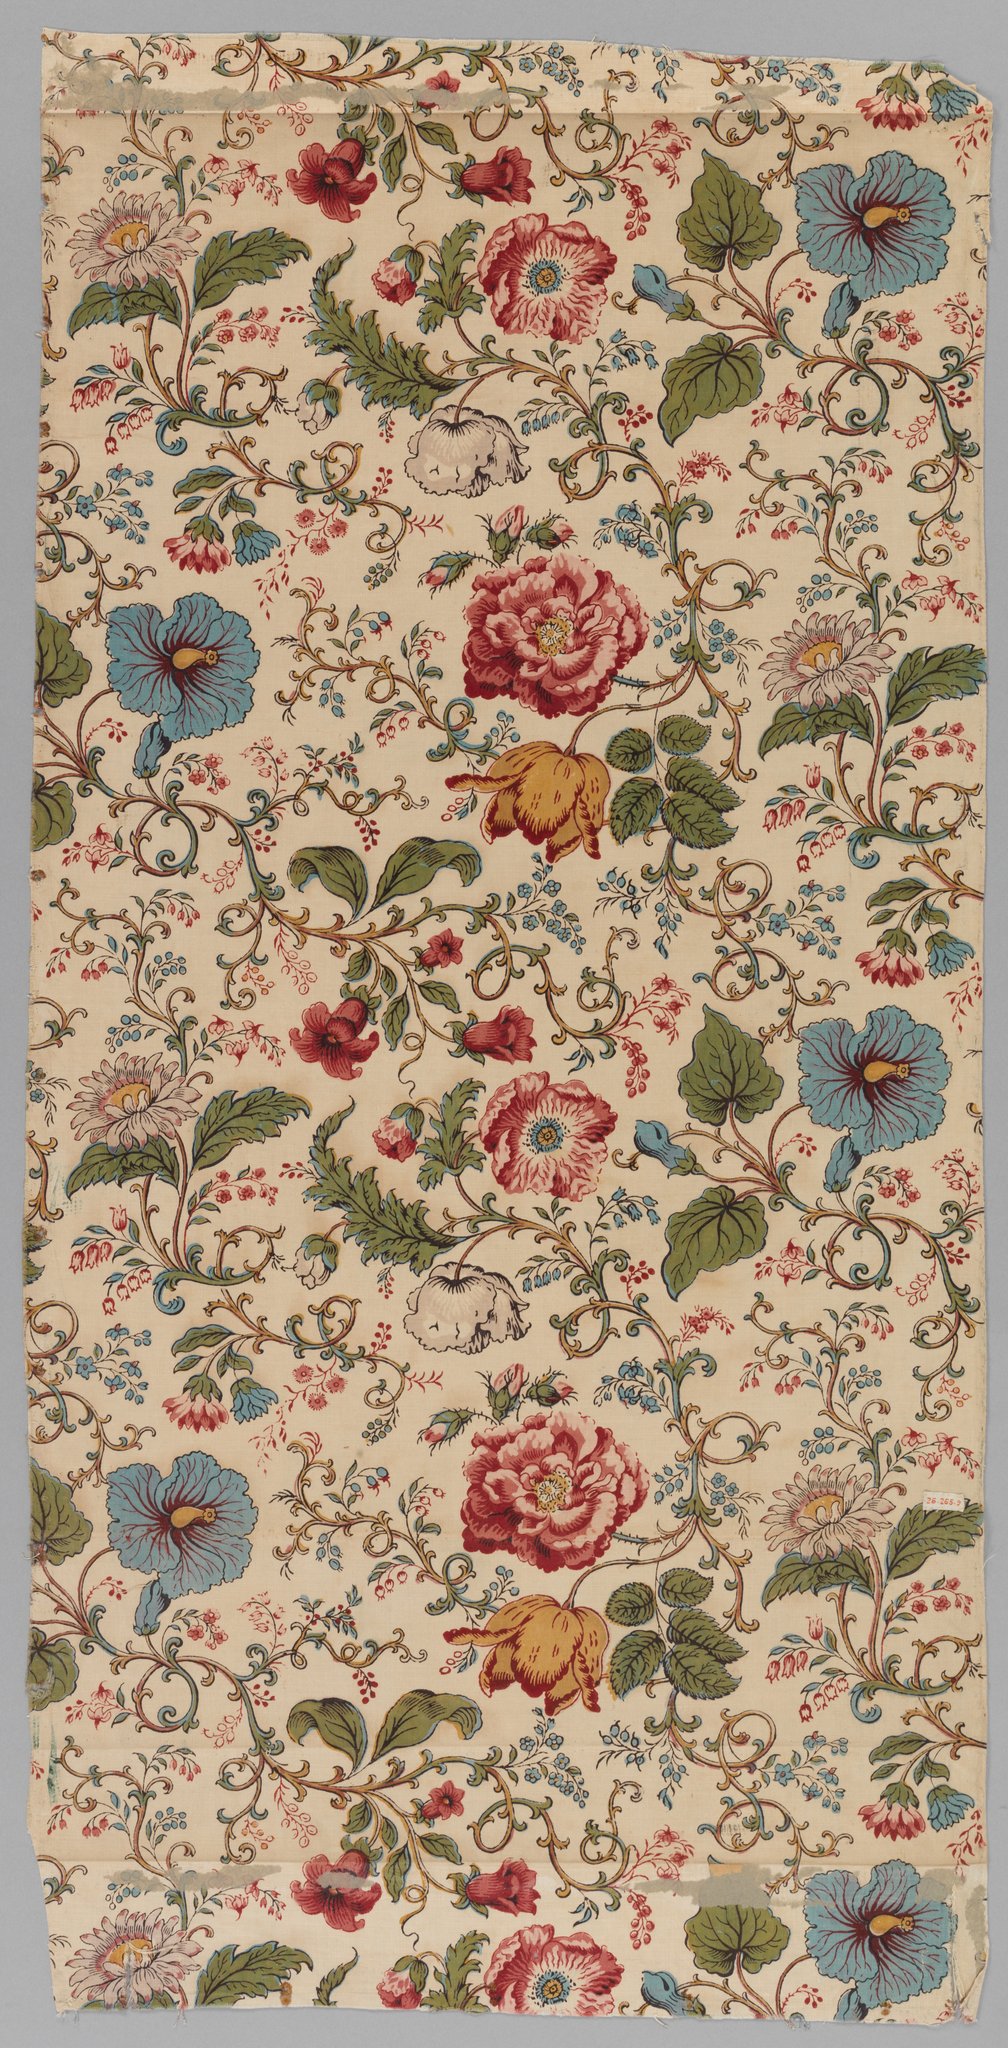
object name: piece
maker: bannister hall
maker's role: manufactory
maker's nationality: british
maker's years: 1793-1893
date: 1833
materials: cotton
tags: flowers,leaves